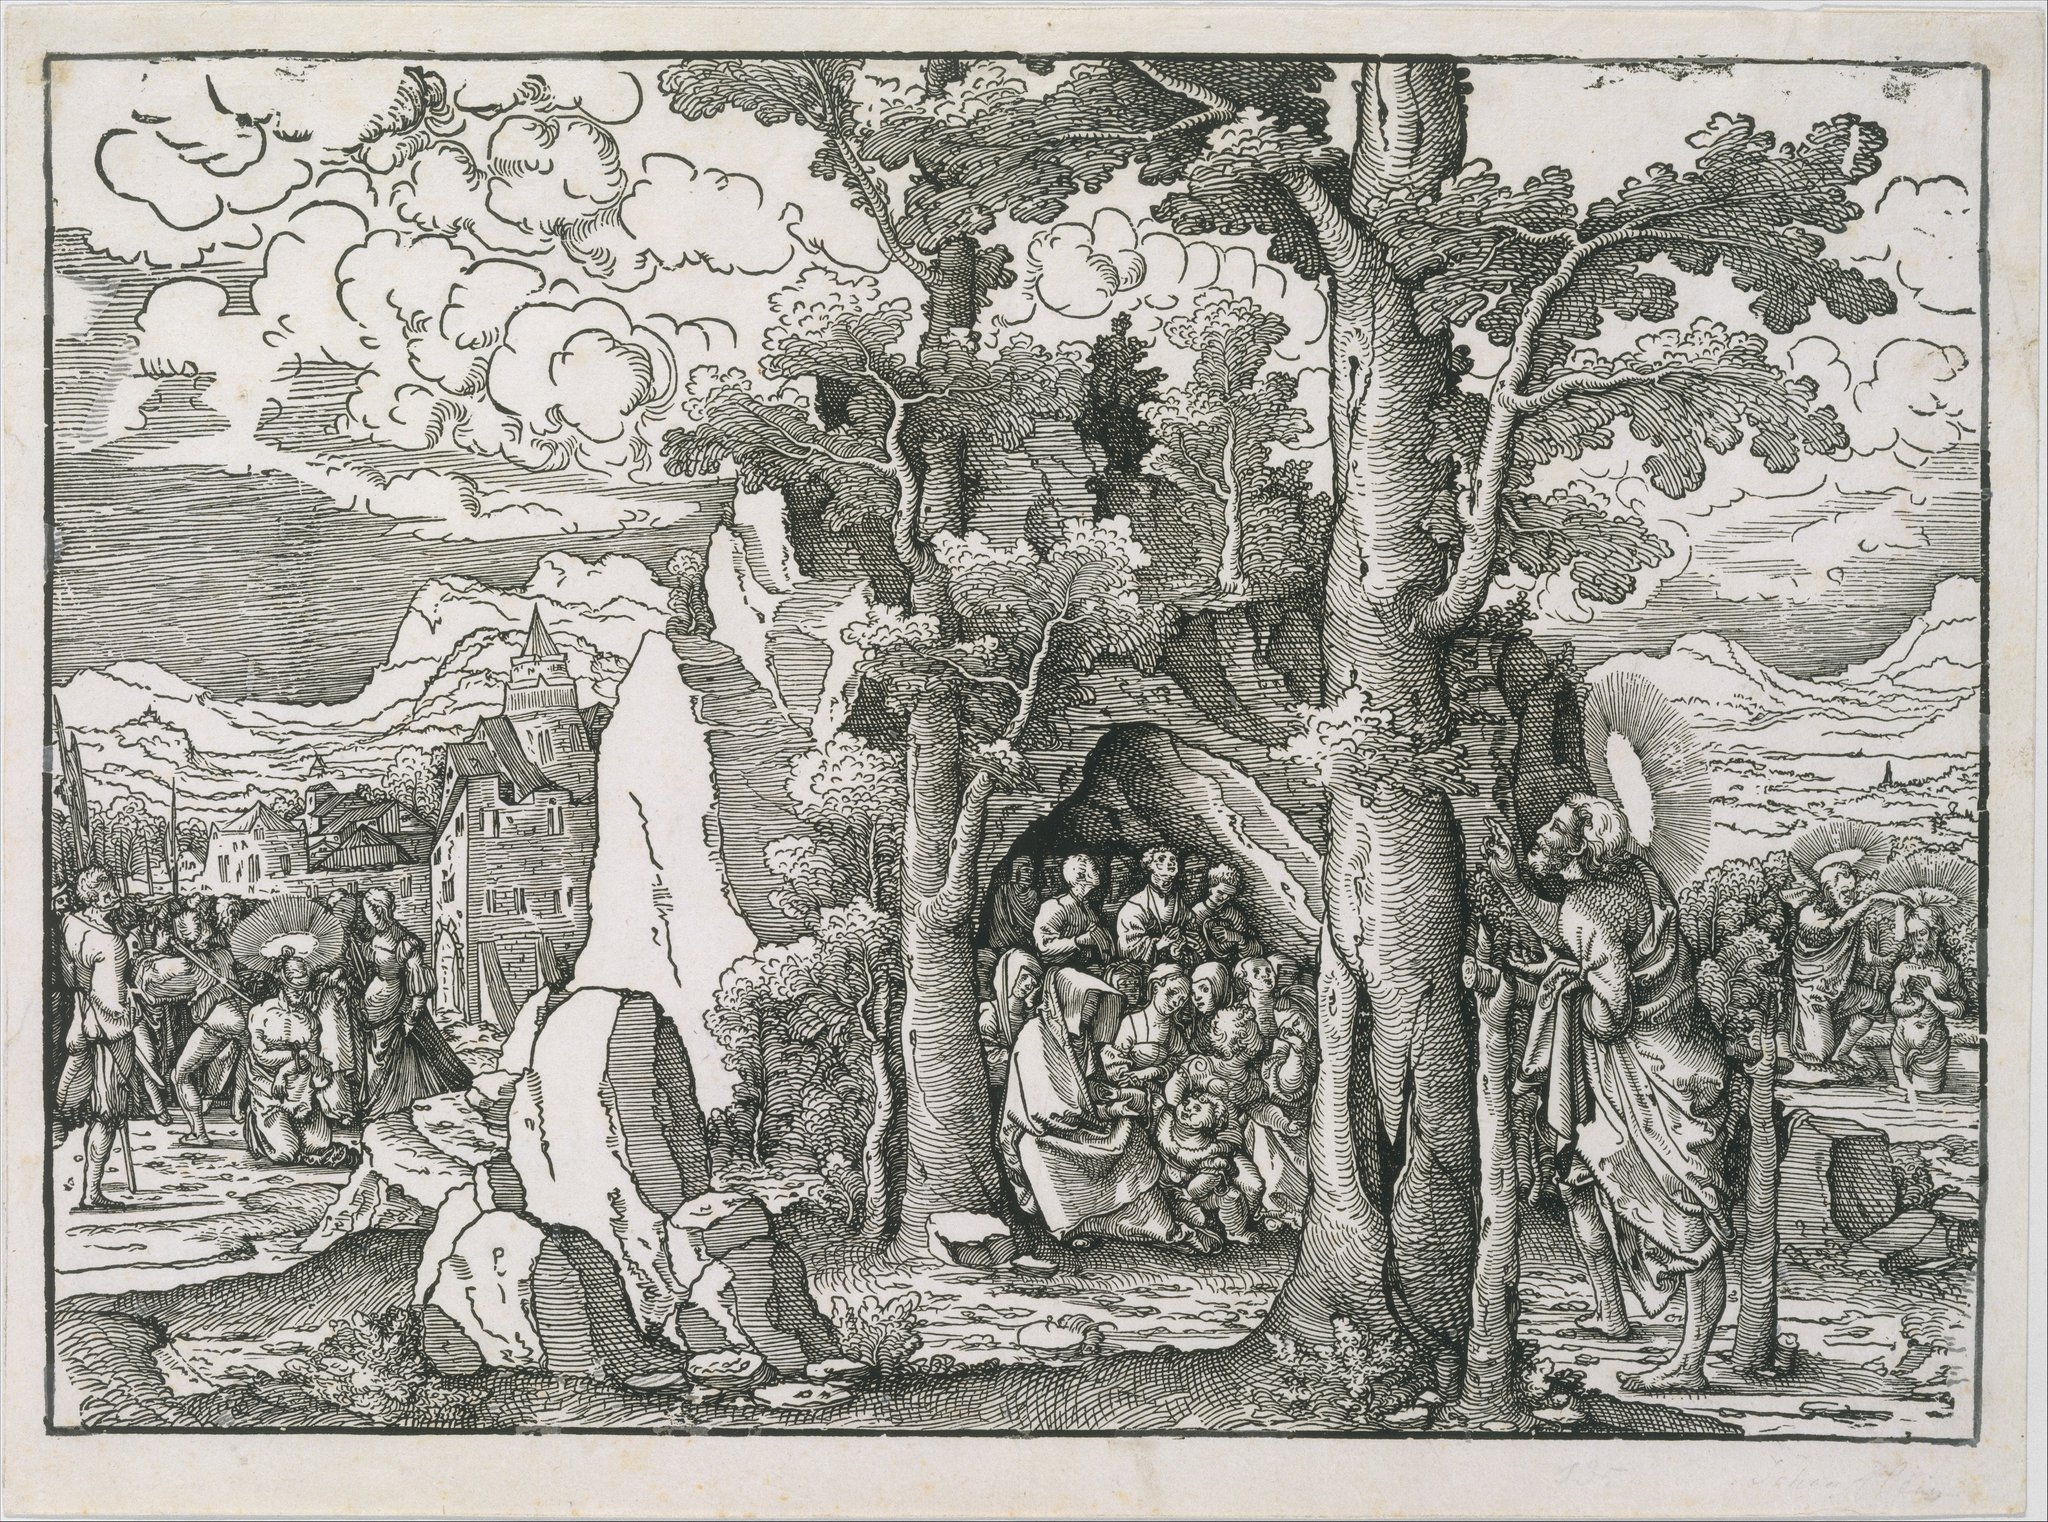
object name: print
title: Scenes from the Life of Saint John the Baptist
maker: frans crabbe van espleghem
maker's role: artist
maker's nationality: netherlandish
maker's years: 1480-1553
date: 1522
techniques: woodcut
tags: buildings,mountains,trees,saint john the baptist,crowd